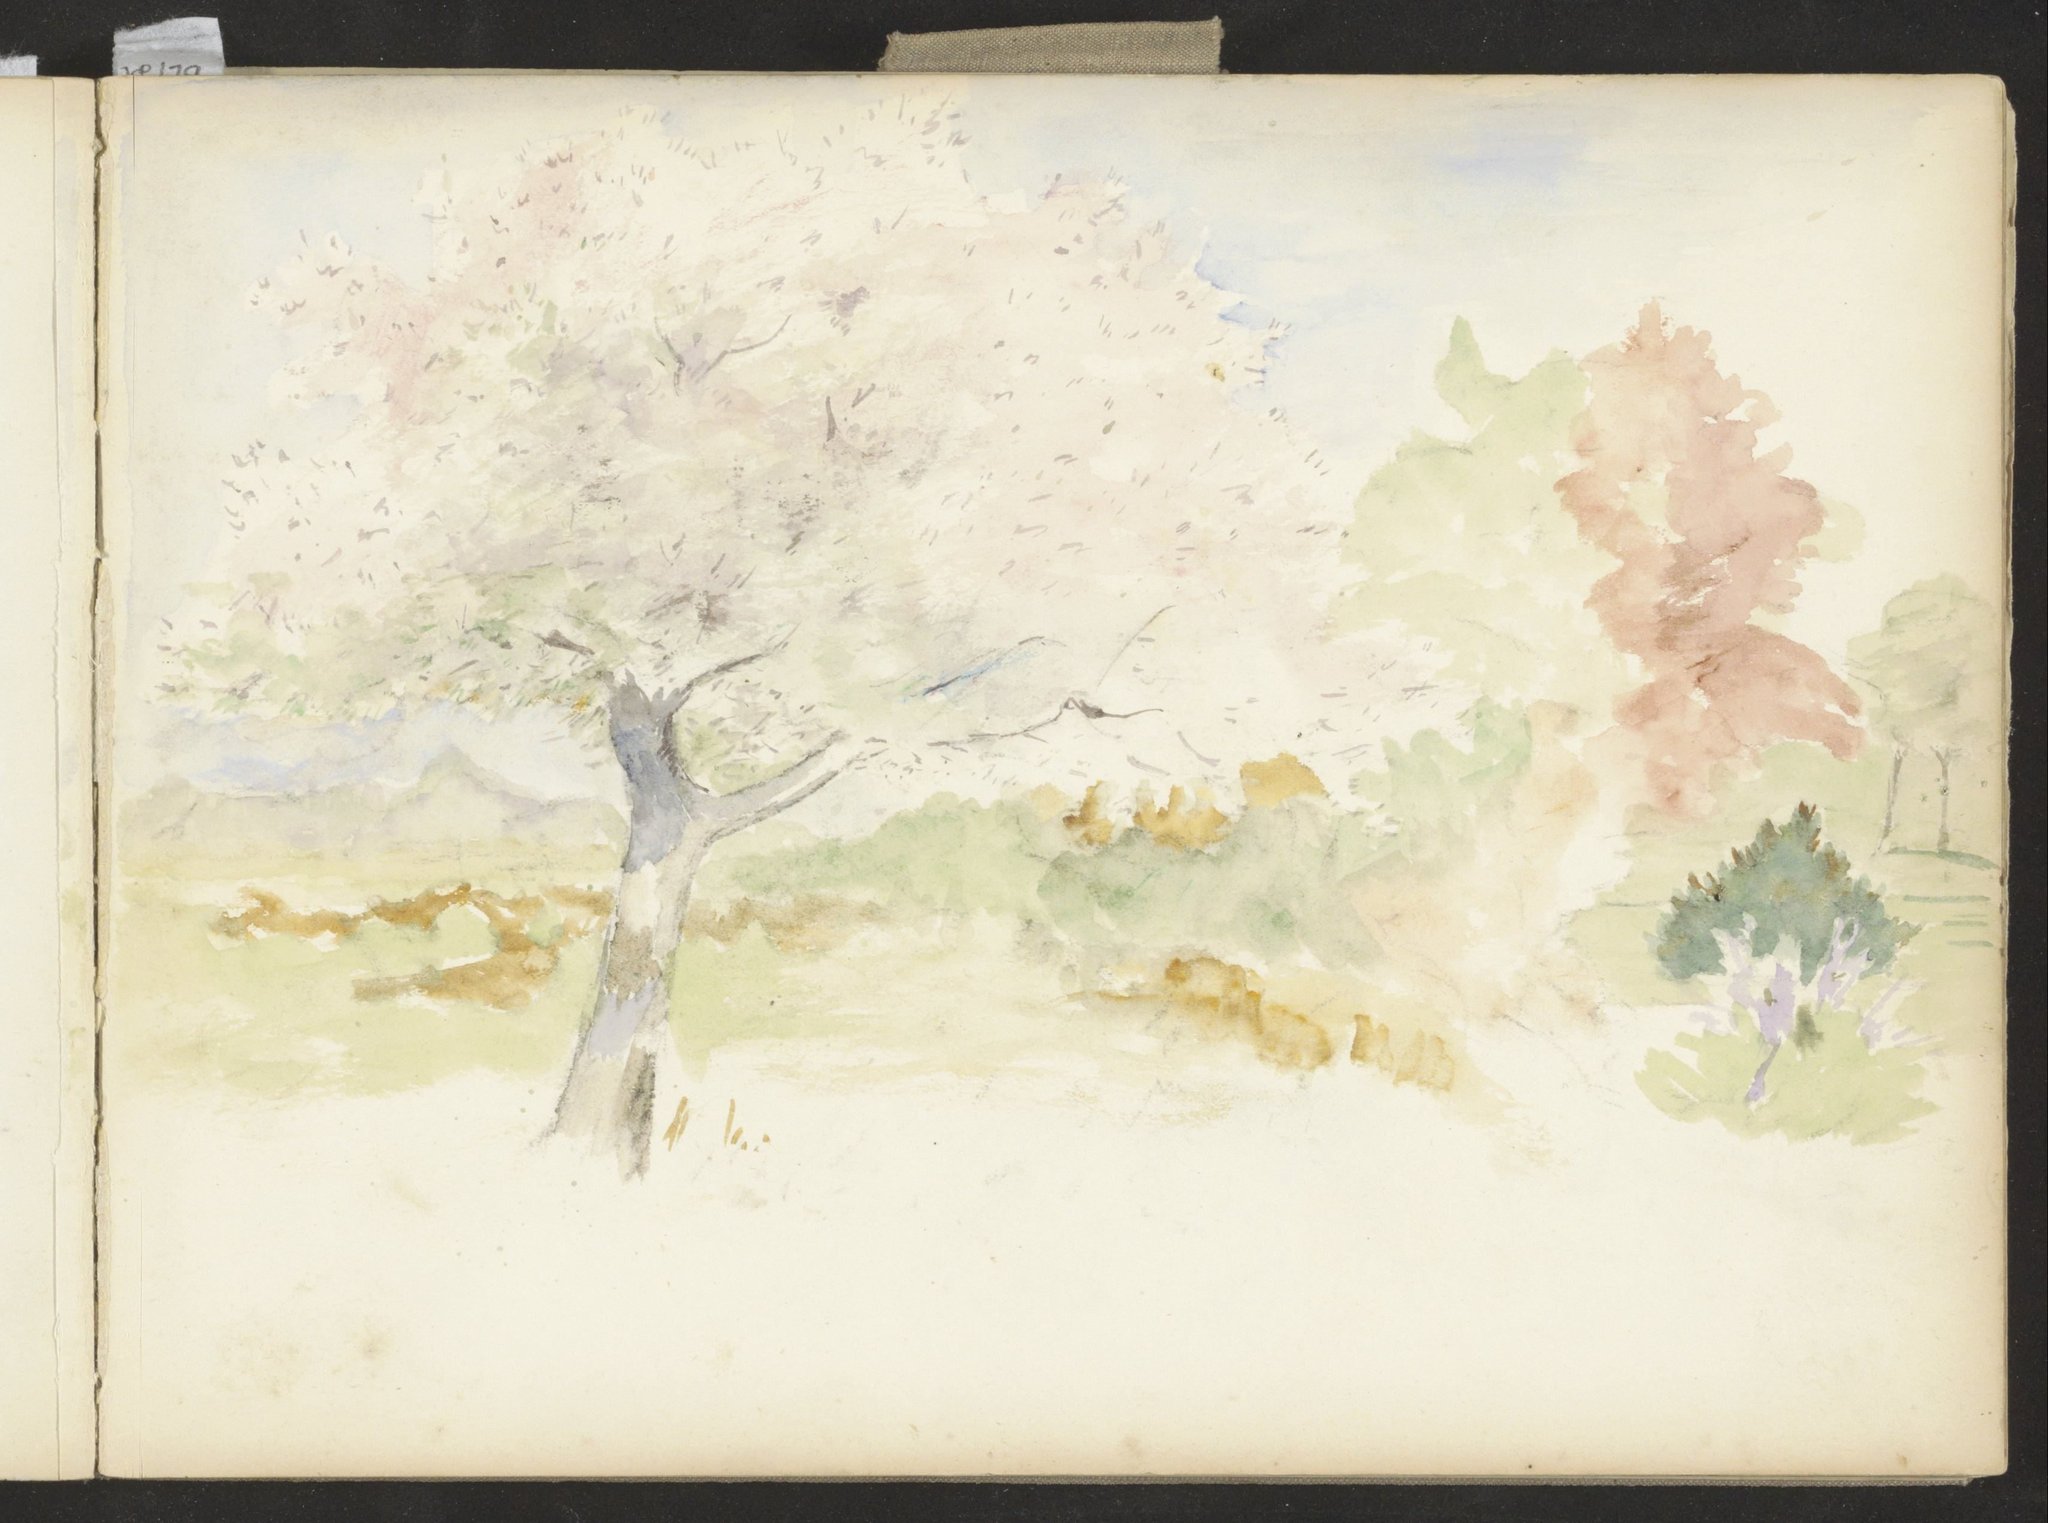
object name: sketchbook leaf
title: Bomen in bloei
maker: jonkheer johannes ludovicus paulus bosch van drakestein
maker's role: draughtsman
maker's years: 1865-1929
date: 1913-1916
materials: paper, pencil, watercolor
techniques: brush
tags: trees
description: Blad 10 recto uit een schetsboek met 47 bladen.